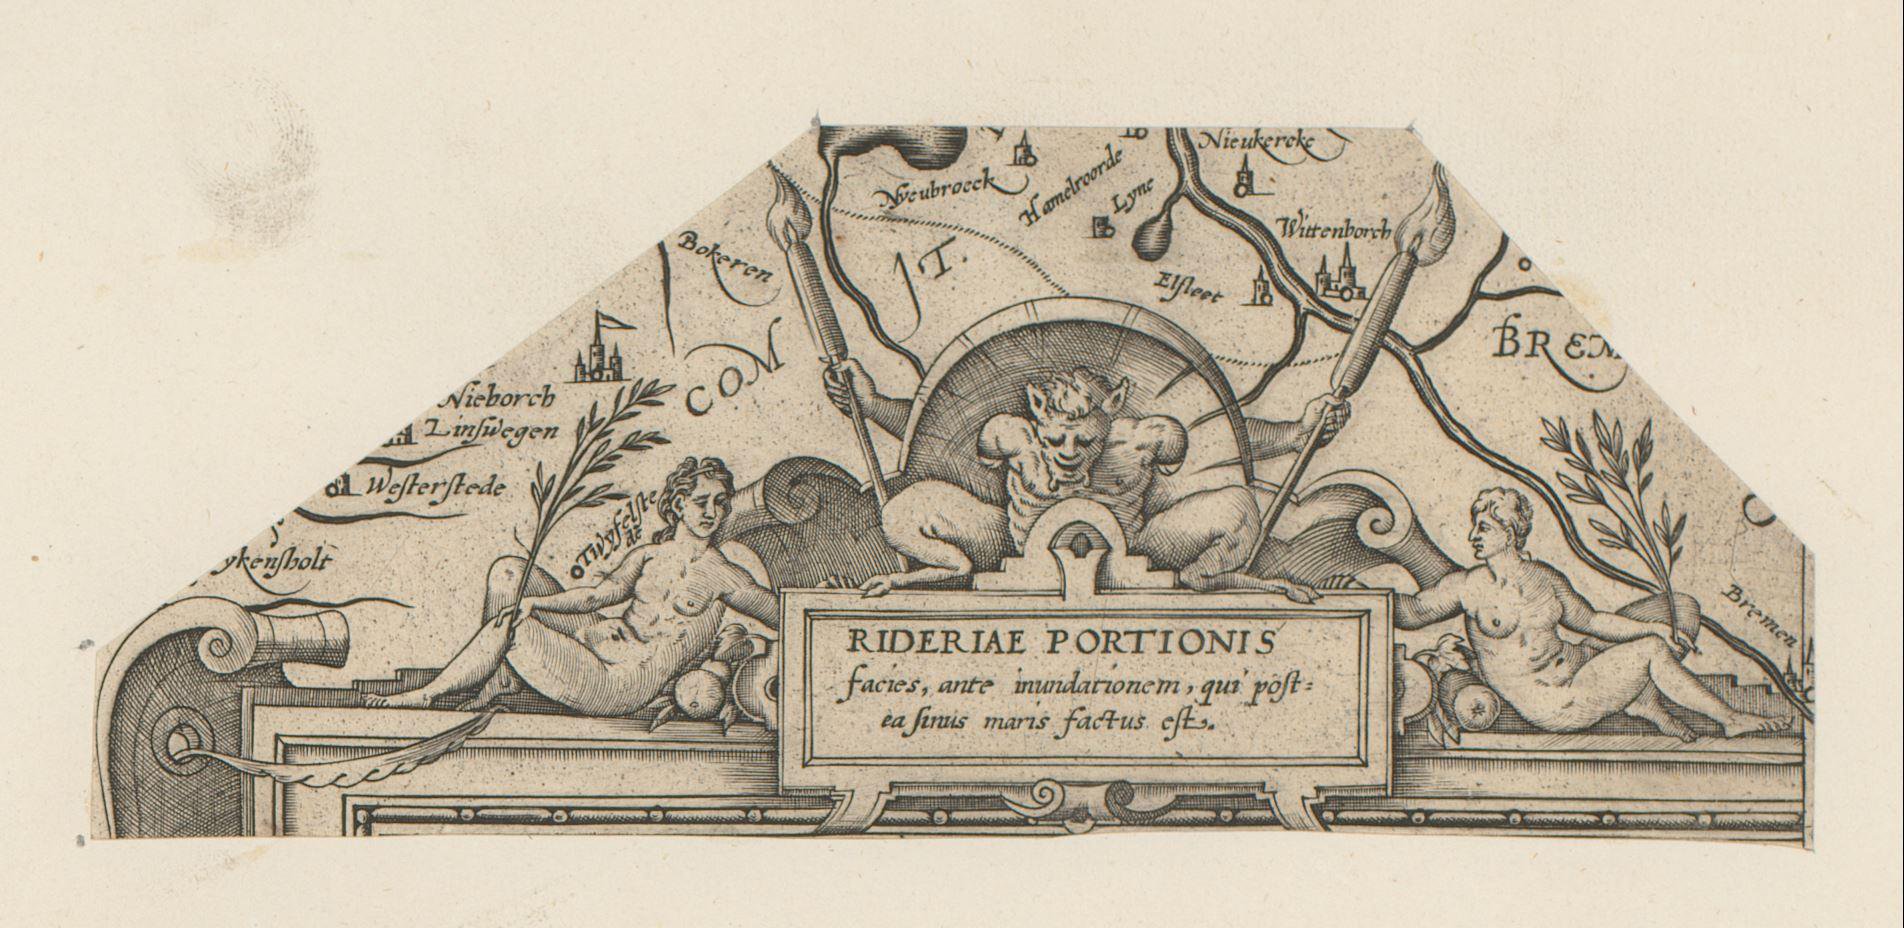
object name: ornament print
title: Frisia Orientalis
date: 1592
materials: paper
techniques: engraving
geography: antwerp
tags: satyr(s) (in general), ornament ~ cartouche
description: Rechthoekige cartouche met midden boven een sater met twee toortsen. Links en recht twee naakte vrouwen met een tak. De cartouche is een fragment van een kaart van Oost-Friesland. De prent maakt deel uit van een album.